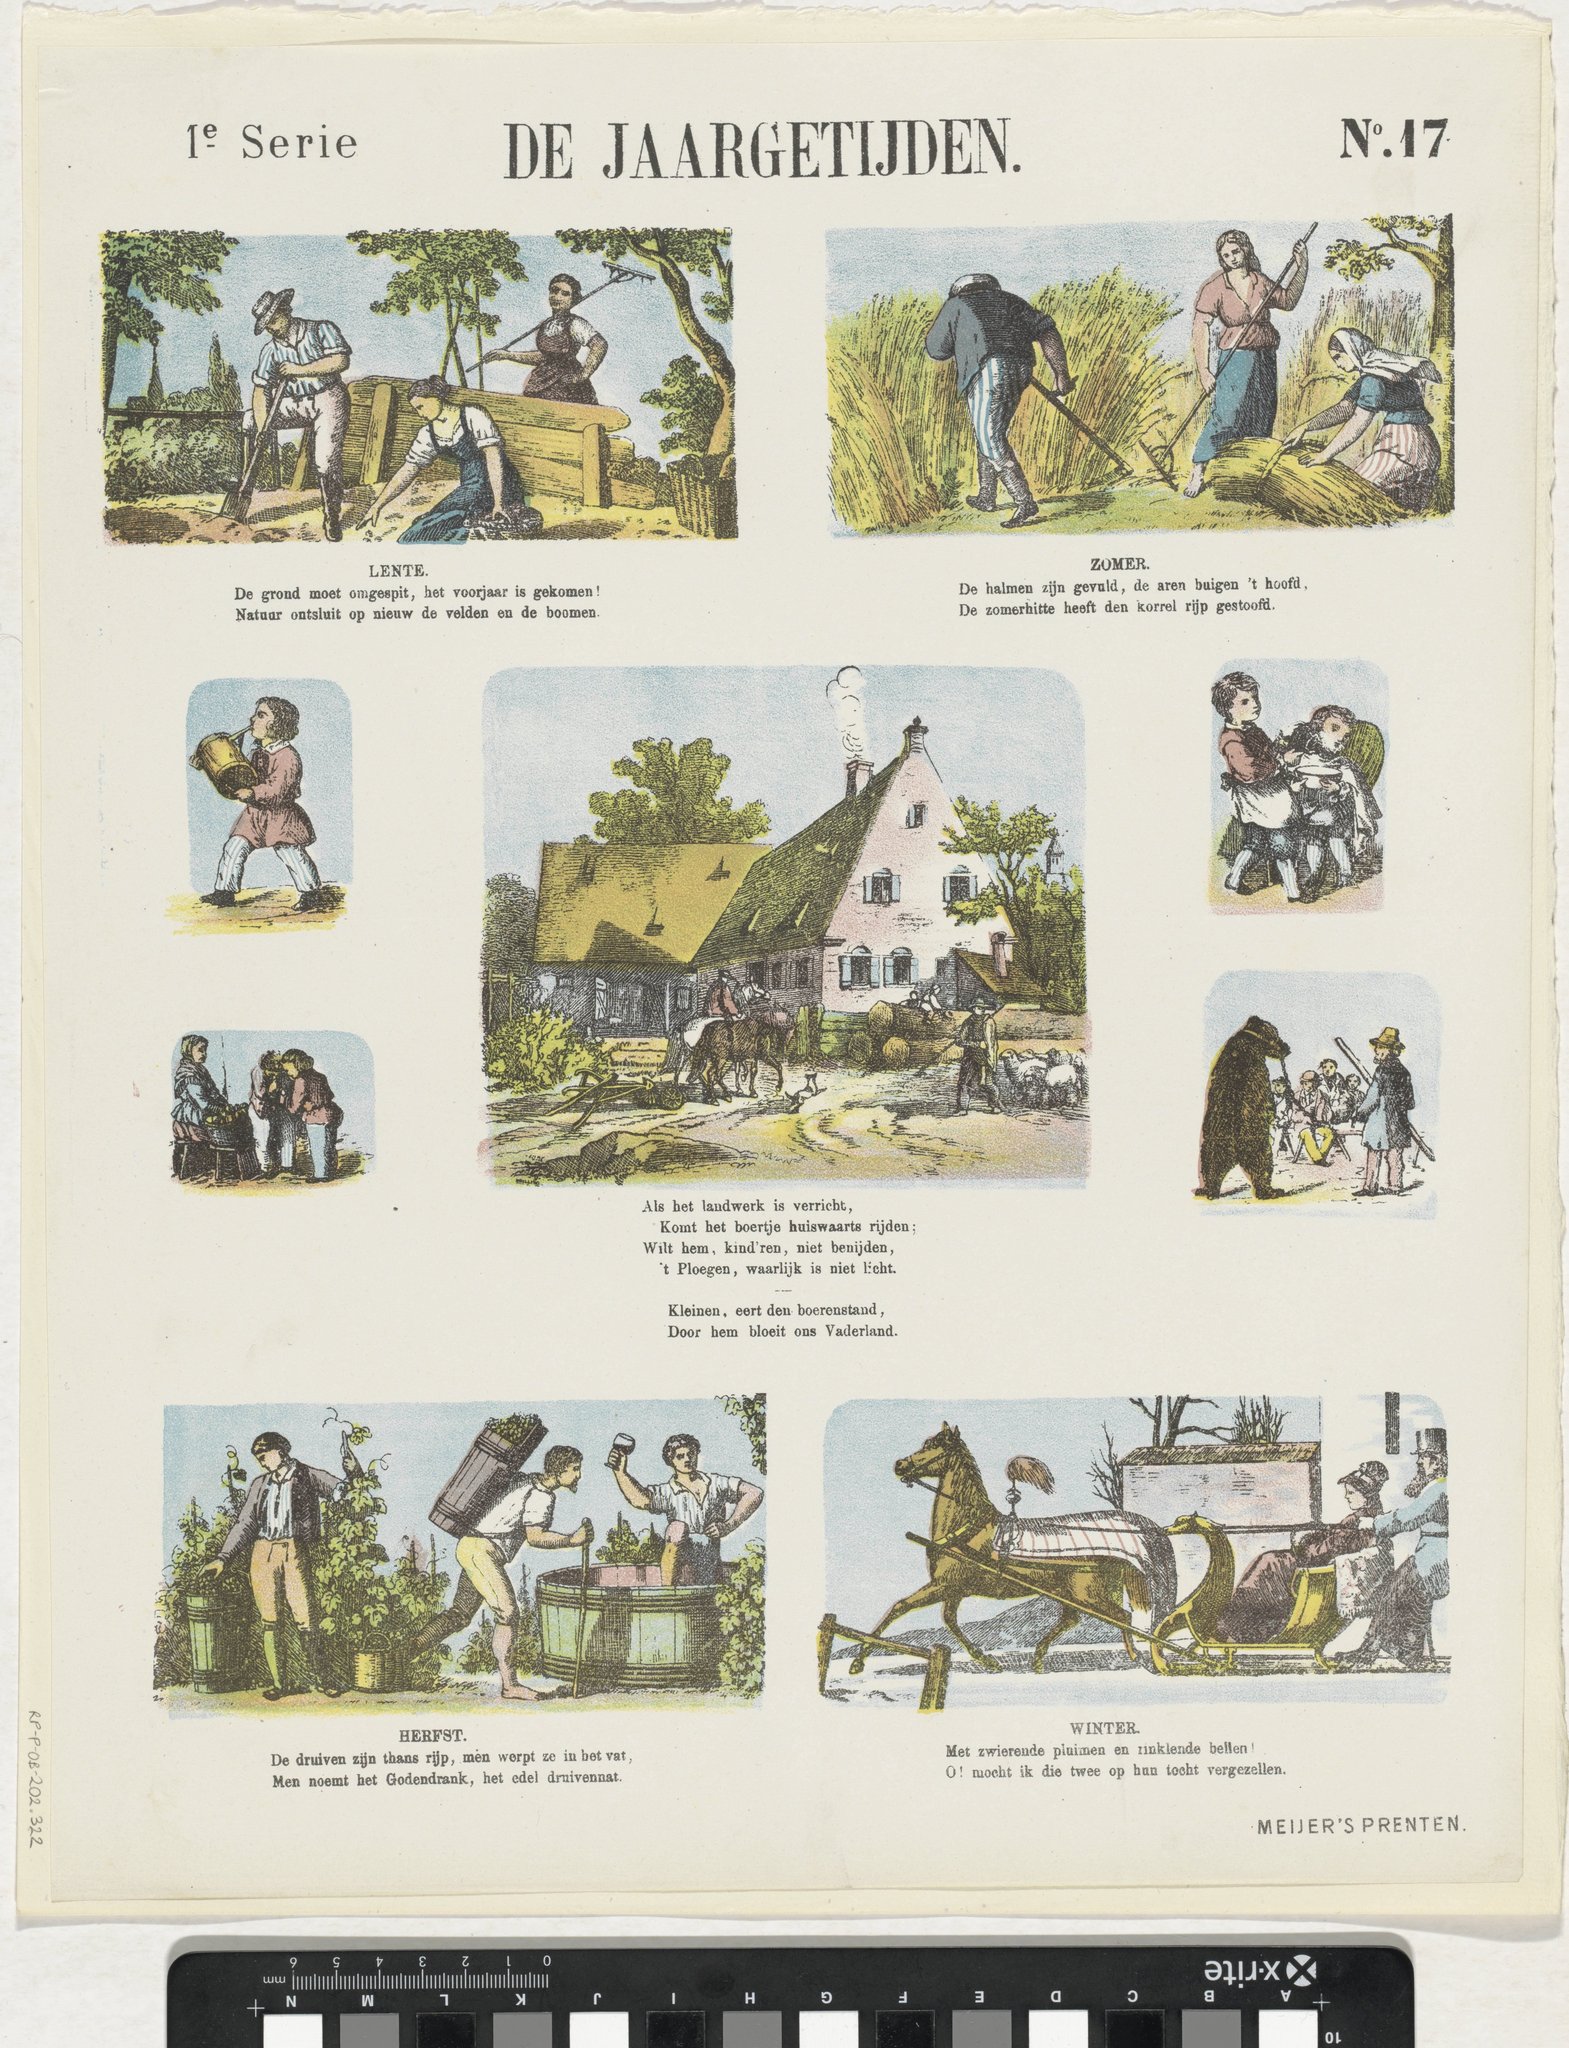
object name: popular print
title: De jaargetijden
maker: Anonymous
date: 1873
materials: paper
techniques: lithograph, letterpress printing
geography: amsterdam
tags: children's games and plays, earning money with bear, the four seasons of the year ~ human activities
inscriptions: collector's mark: Lugt 2760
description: Blad met 9 voorstellingen van de vier jaargetijden, spelende kinderen en een berentemmer. Onder enkele afbeeldingen een onderschrift. Genummerd rechtsboven: No. 17.